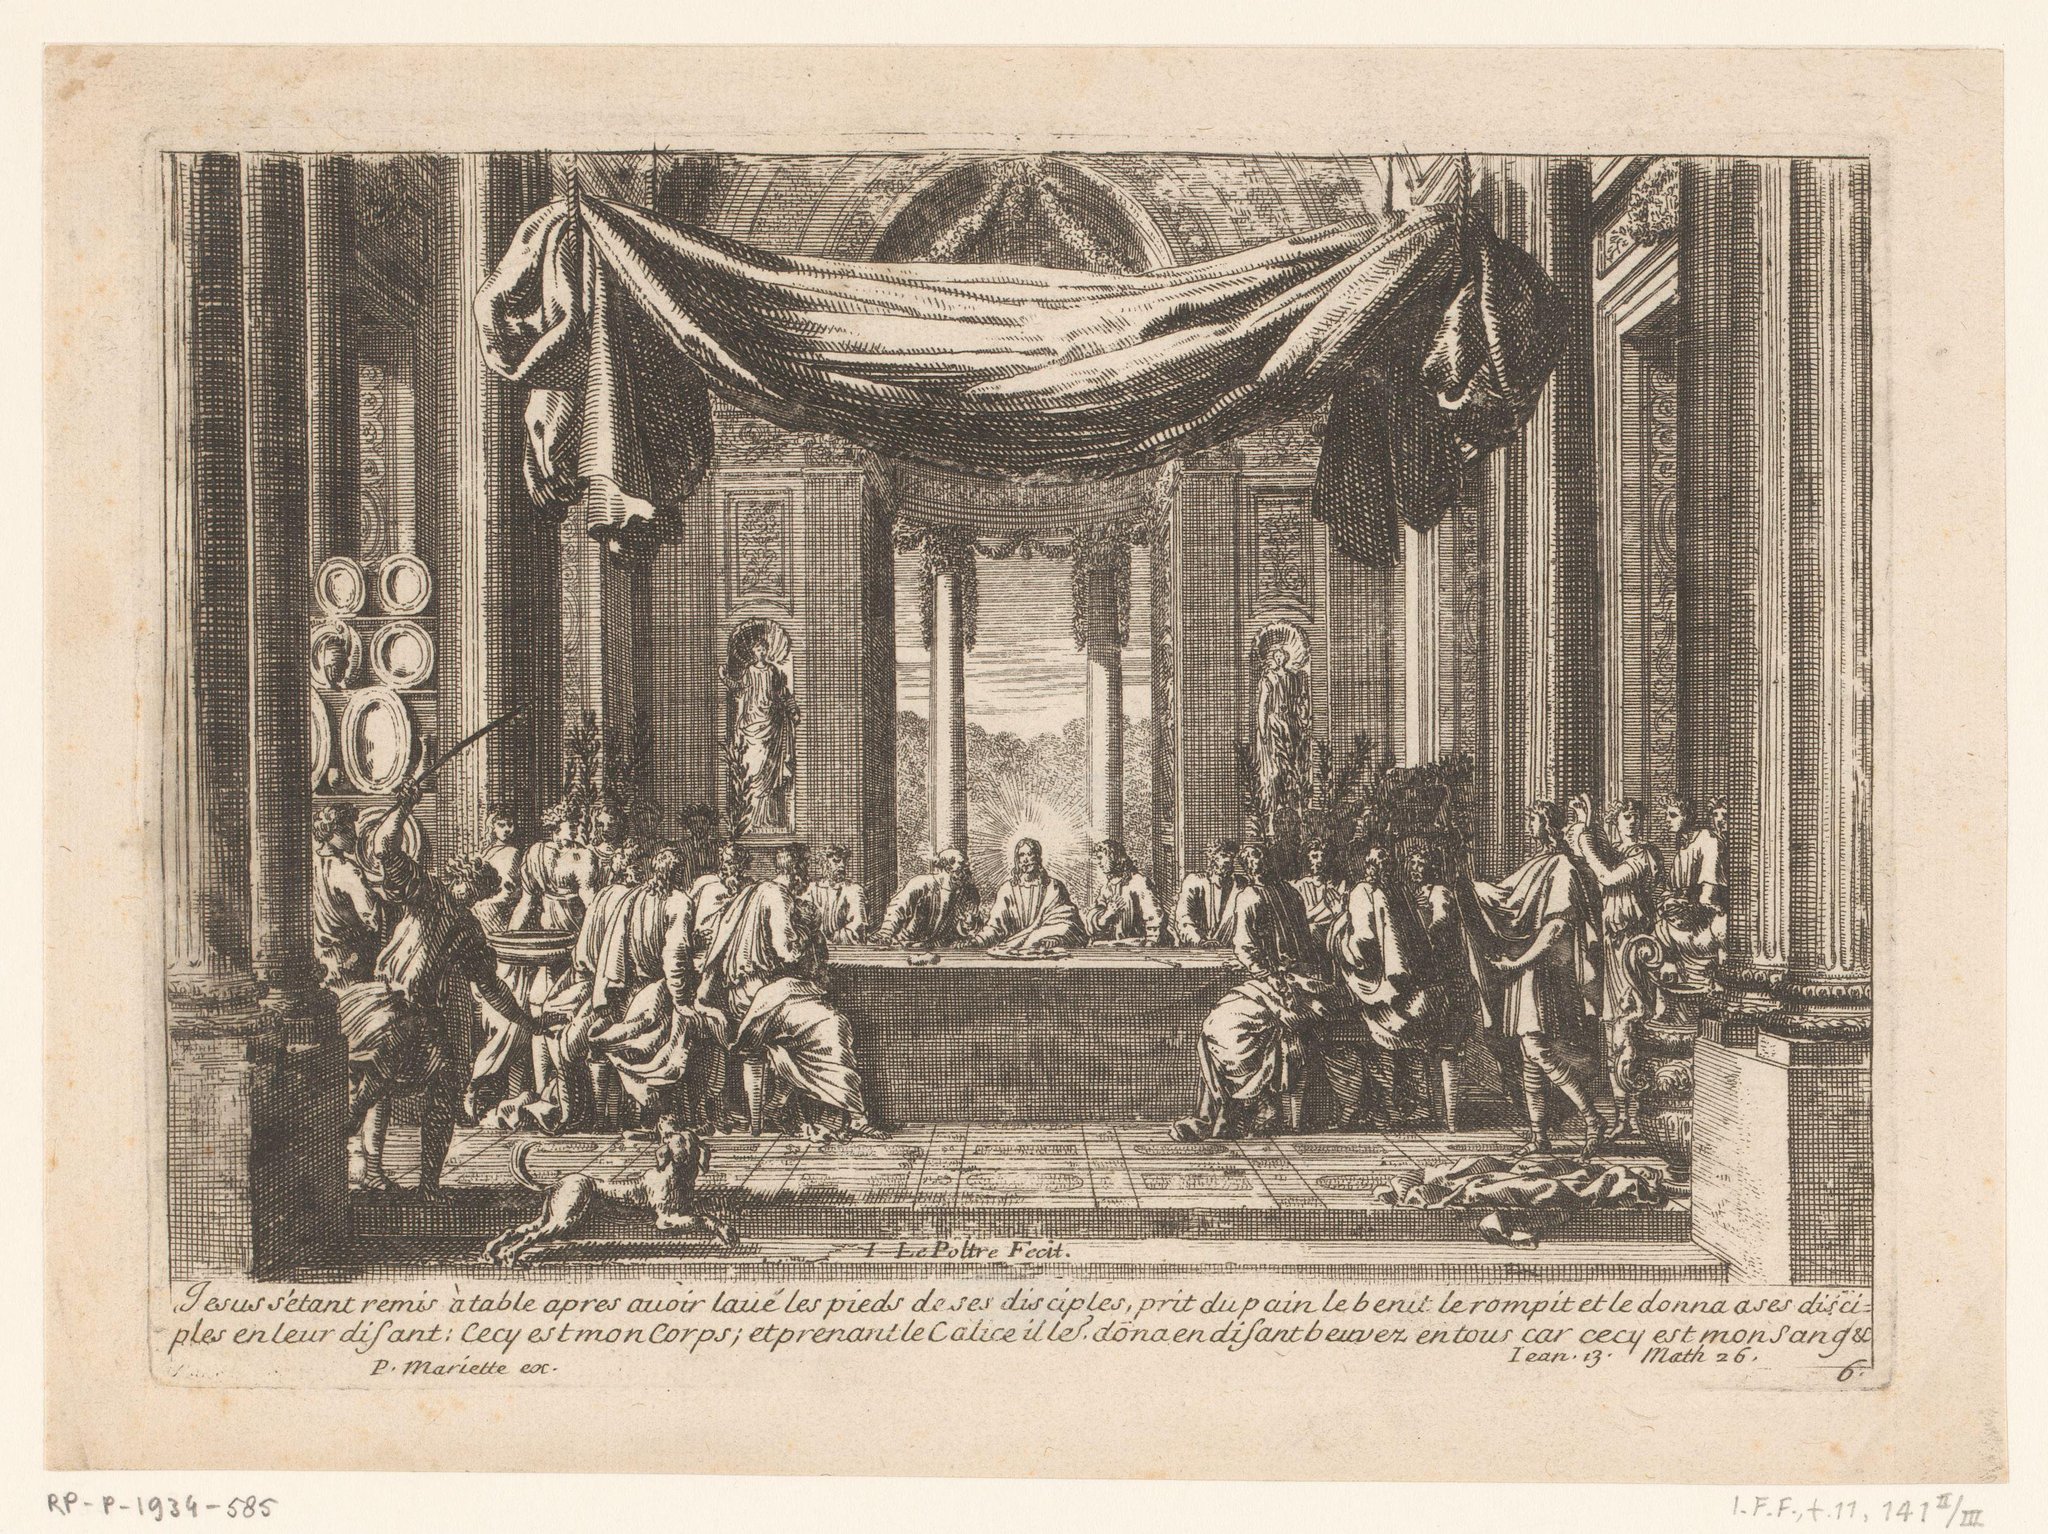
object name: print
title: Laatste avondmaal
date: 1628-1682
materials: paper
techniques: etching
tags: the episode of the last supper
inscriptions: collector's mark: Lugt 2228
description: Maakt deel uit van een zesdelige serie met scènes uit het leven van Christus, opgedragen aan François de Rostaing. Enkel de laatste plaat uit de serie is door Lepautre gesigneerd. Zie IFF 17e siècle, p. 101.